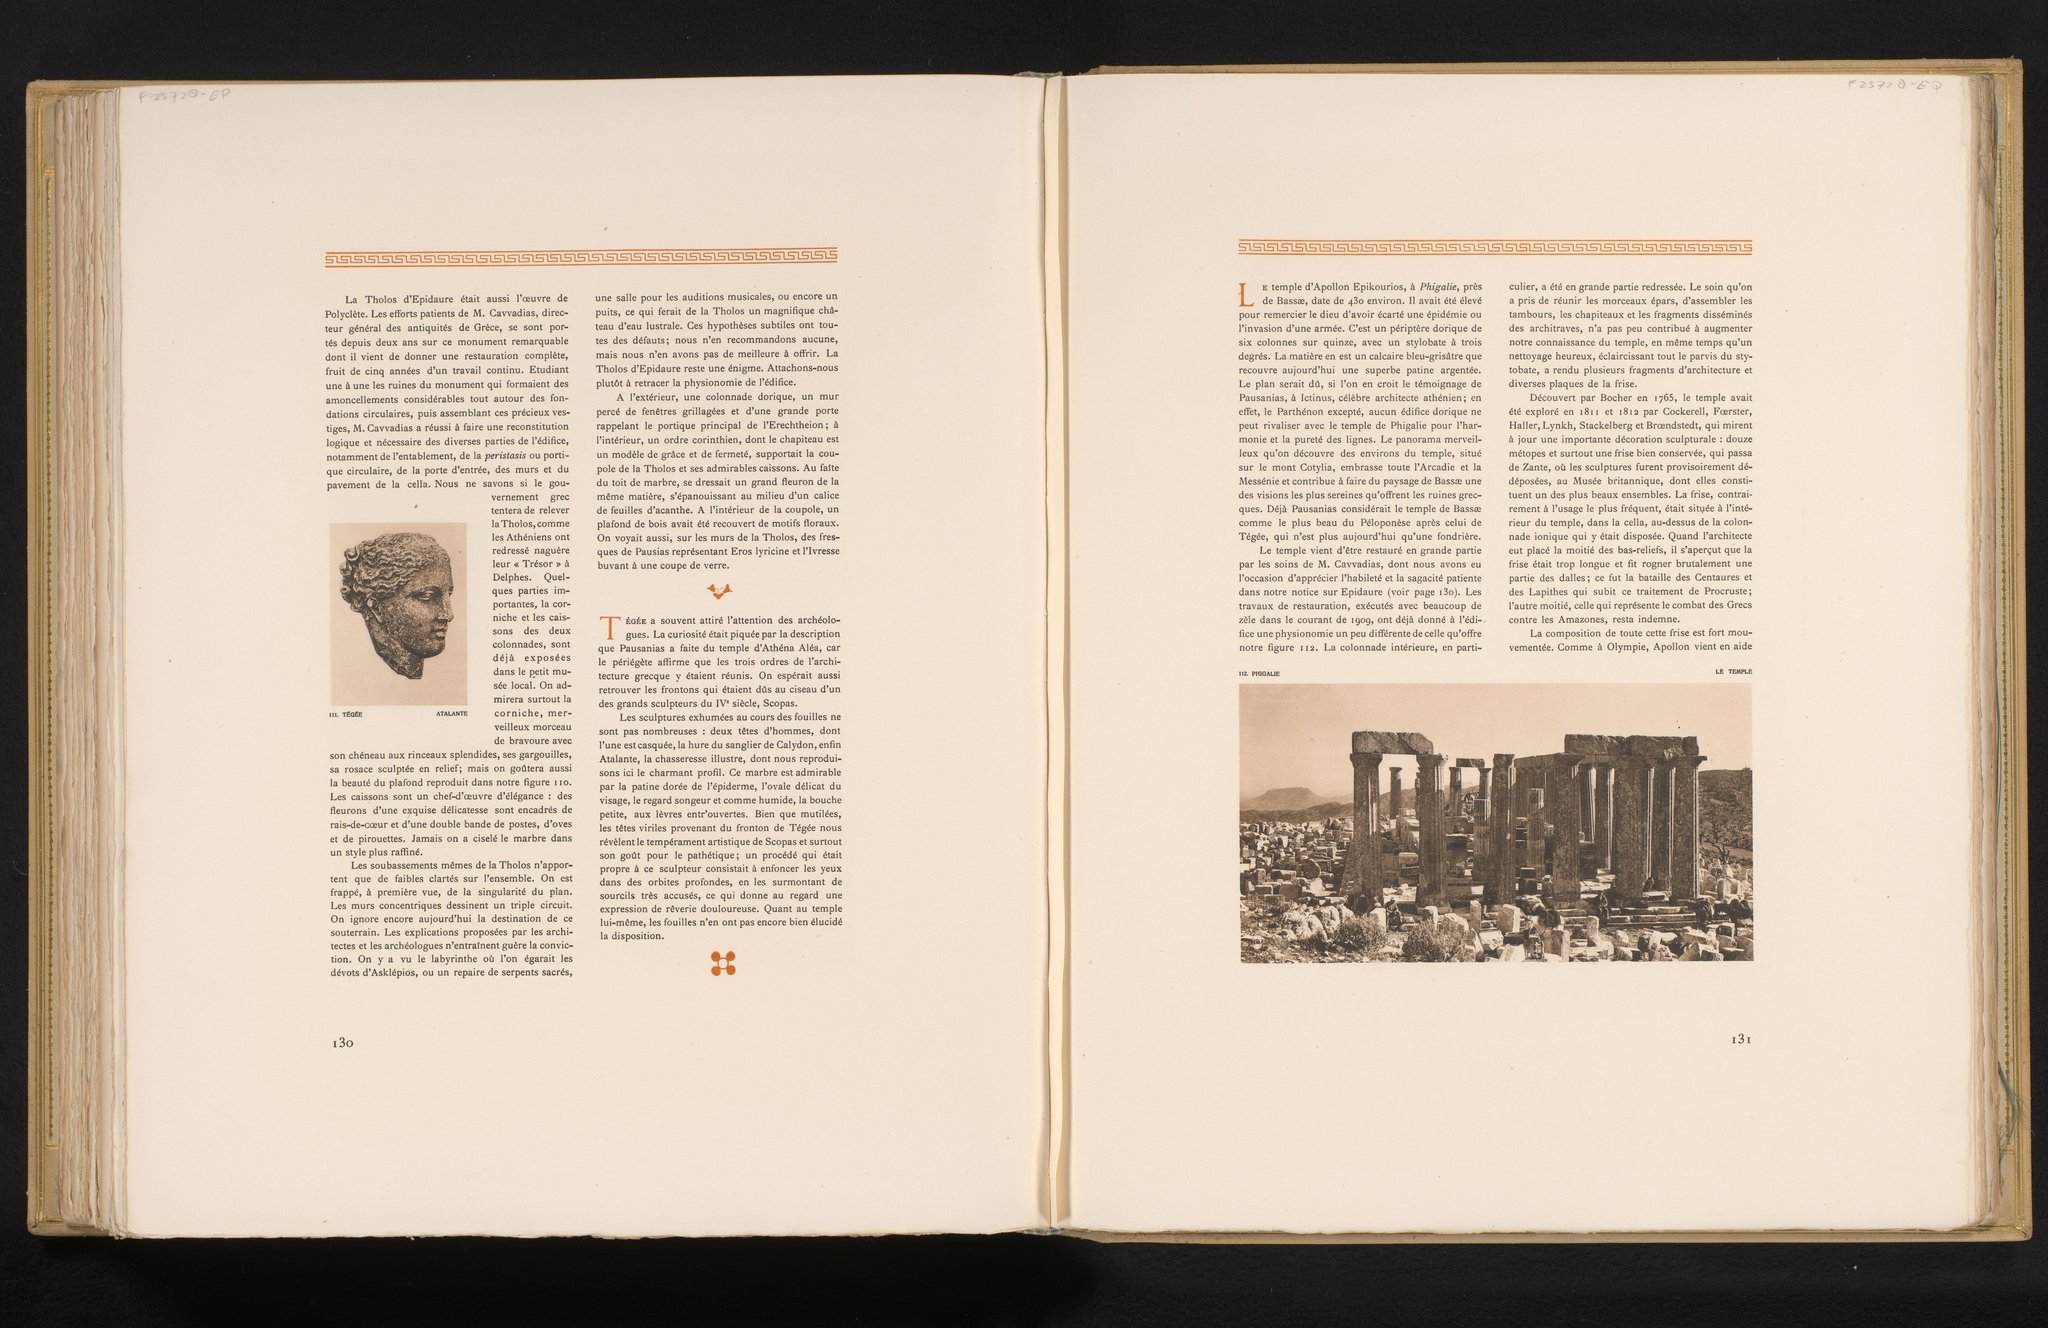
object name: page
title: Ruïnes in Phigalia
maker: frédéric boissonnas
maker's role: fotograaf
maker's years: 1858-1946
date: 1905-1910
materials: paper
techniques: photograph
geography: berlin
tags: landscape with ruins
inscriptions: number: ‘112.’